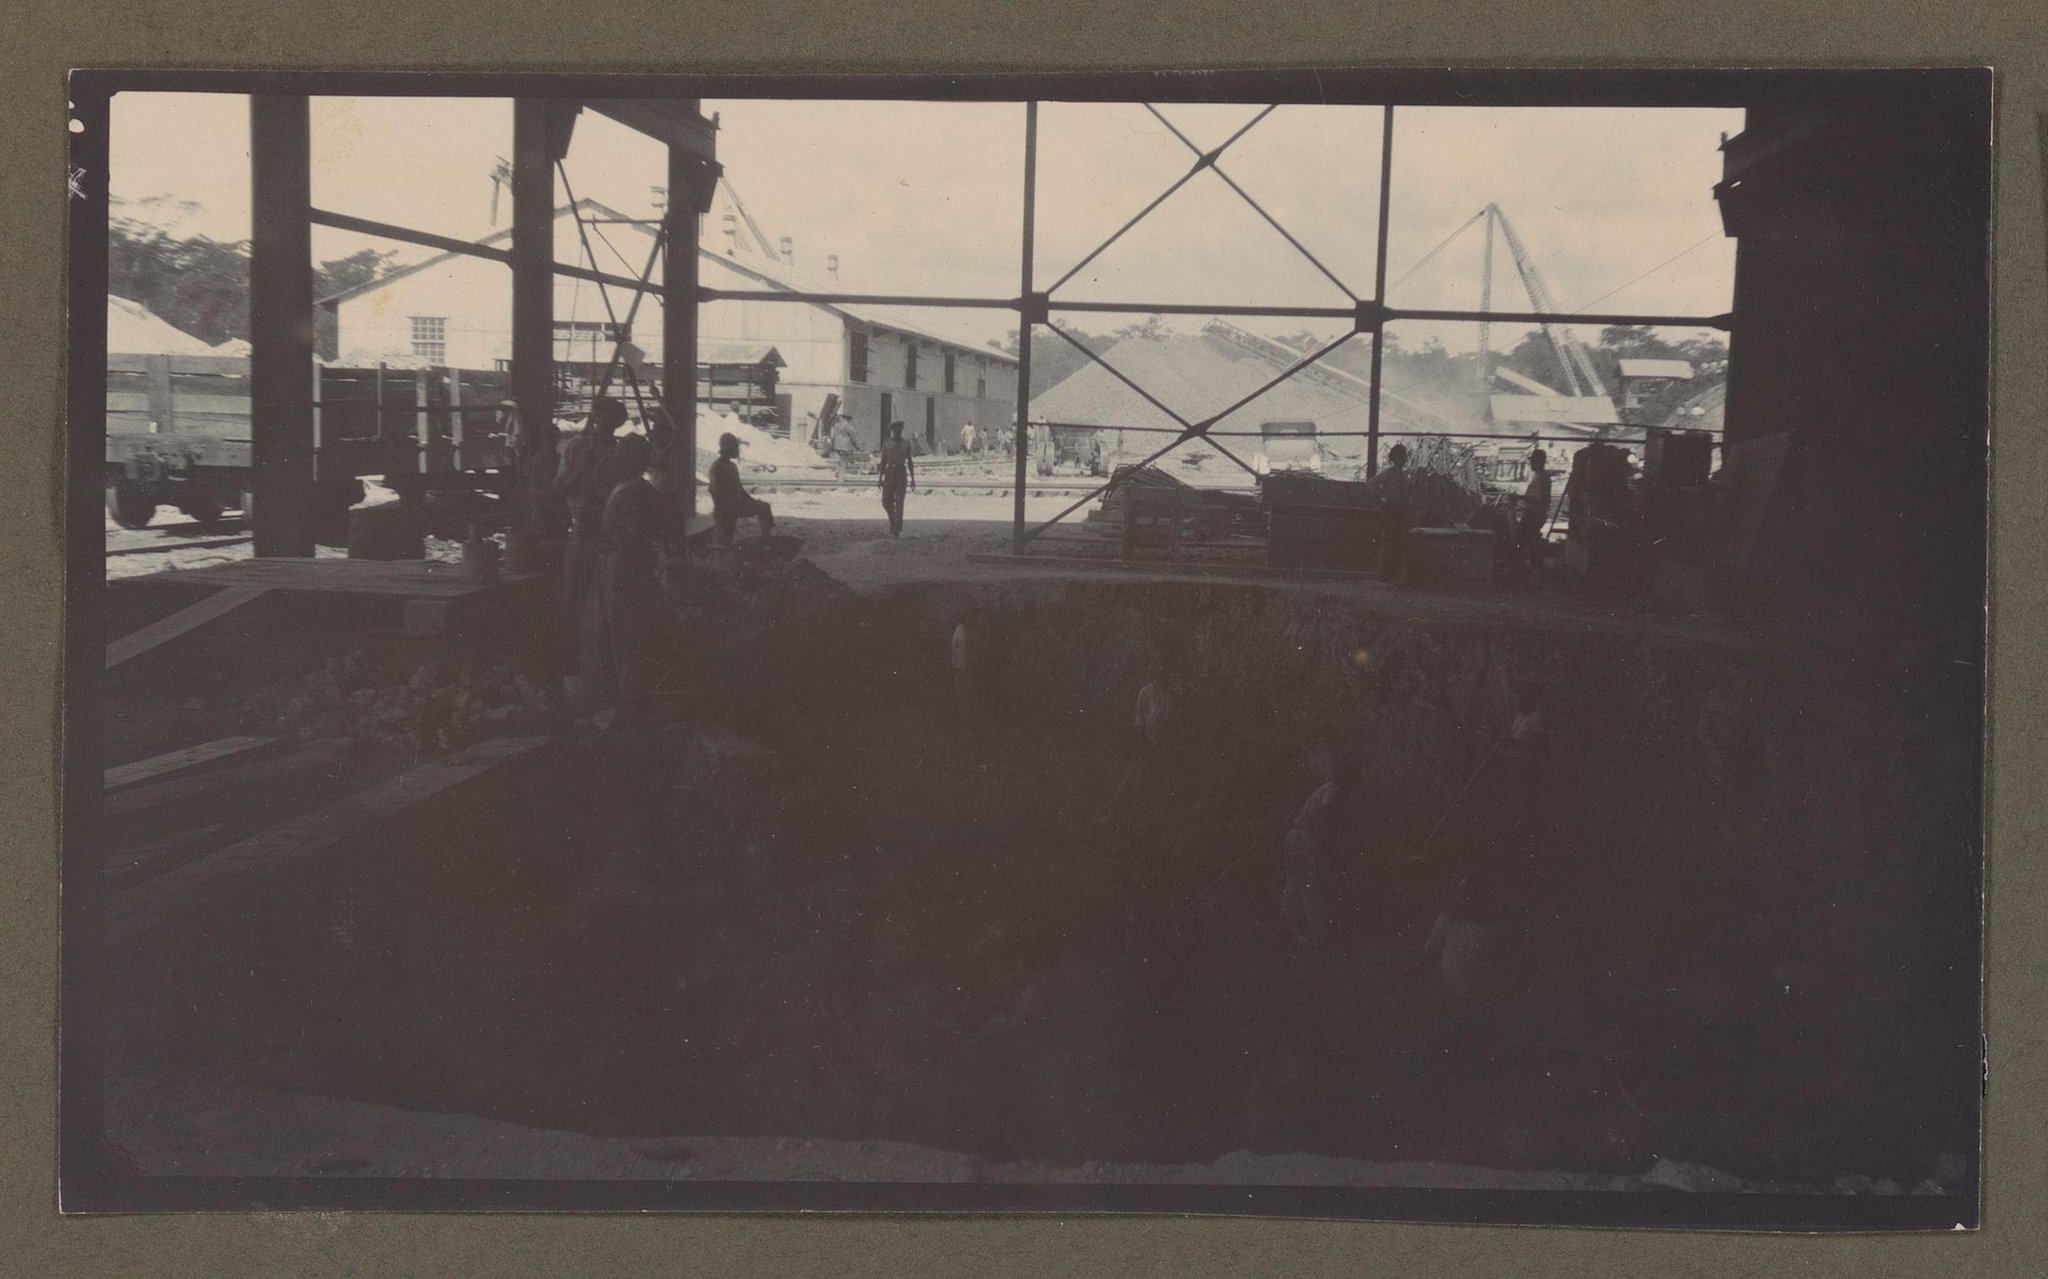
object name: photograph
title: Mijn en fabriek te Moengo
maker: Anonymous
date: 1925-1927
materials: photographic support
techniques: photography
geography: suriname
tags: jetten, familie, moengo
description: Het terrein van de mijn en fabriek te Moengo, interieur. Foto op een bladzijde van een los albumblad. Onderdeel van het ensemble met foto's van de familie van ingenieur Jetten in de mijnbouwstad Moengo in Suriname.